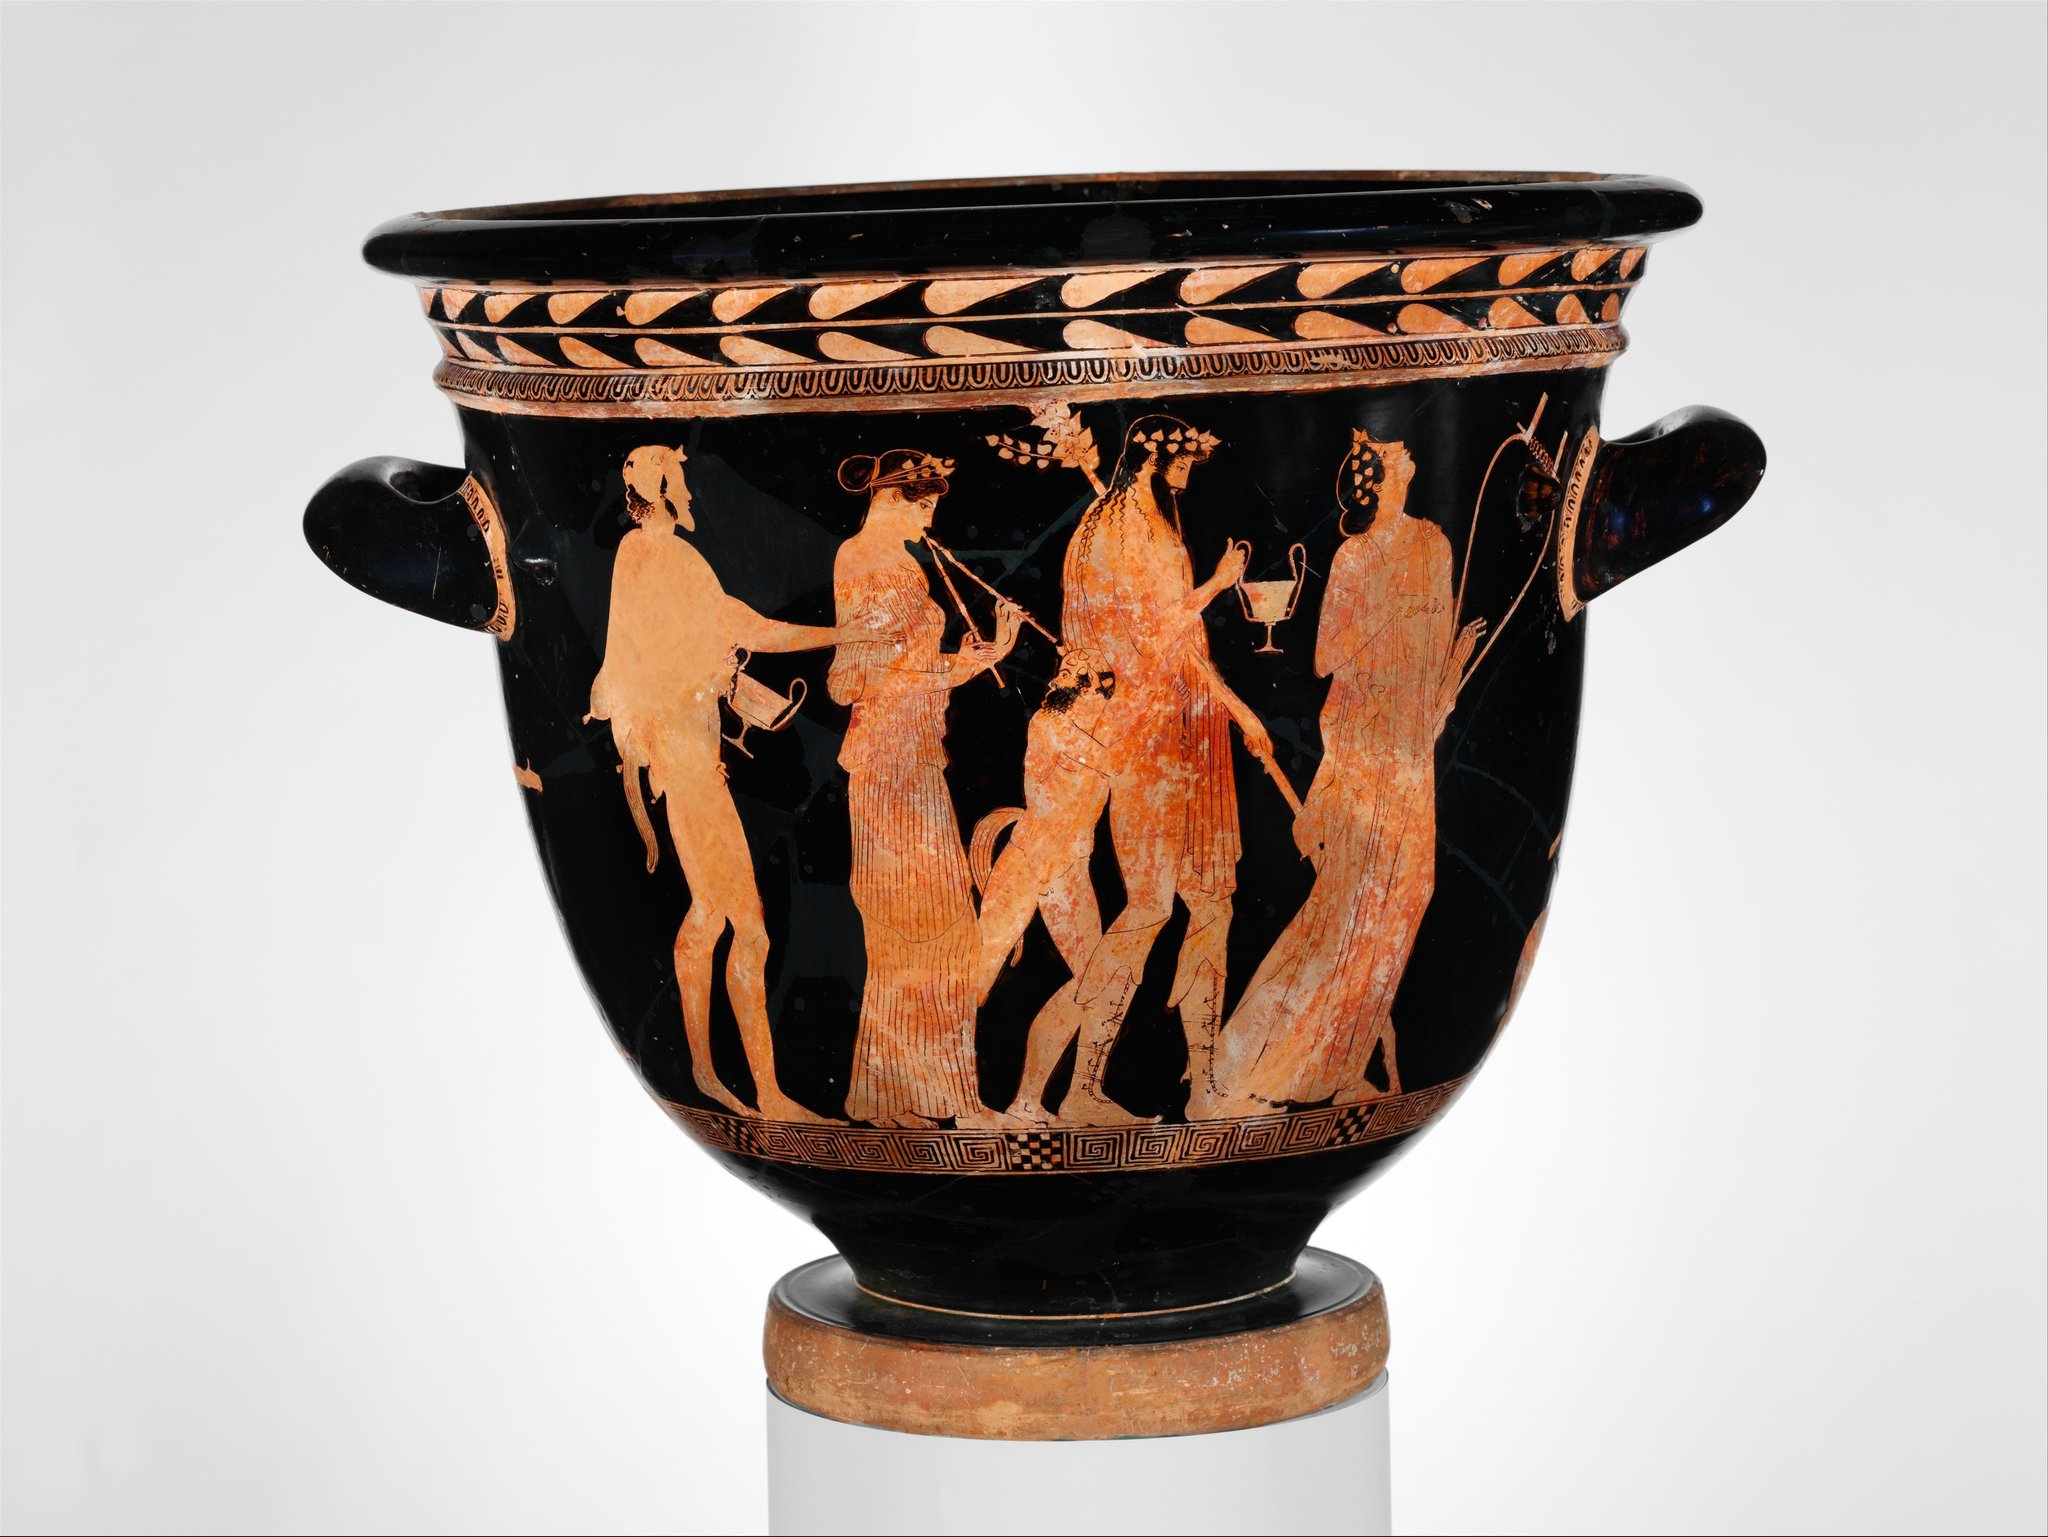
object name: bell krater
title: Terracotta bell-krater (bowl for mixing wine and water)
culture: greek, attic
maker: methyse painter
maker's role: artist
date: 450 BCE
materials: terracotta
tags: male nudes,women,dionysus,maenads,satyrs